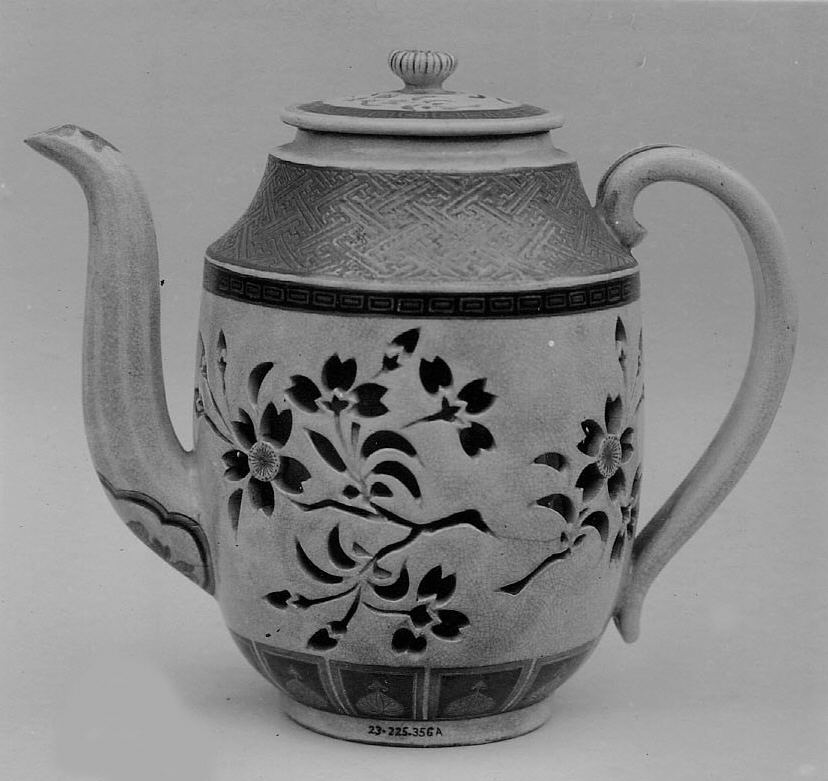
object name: wine pot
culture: japanese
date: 1870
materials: enamel, faience, glaze